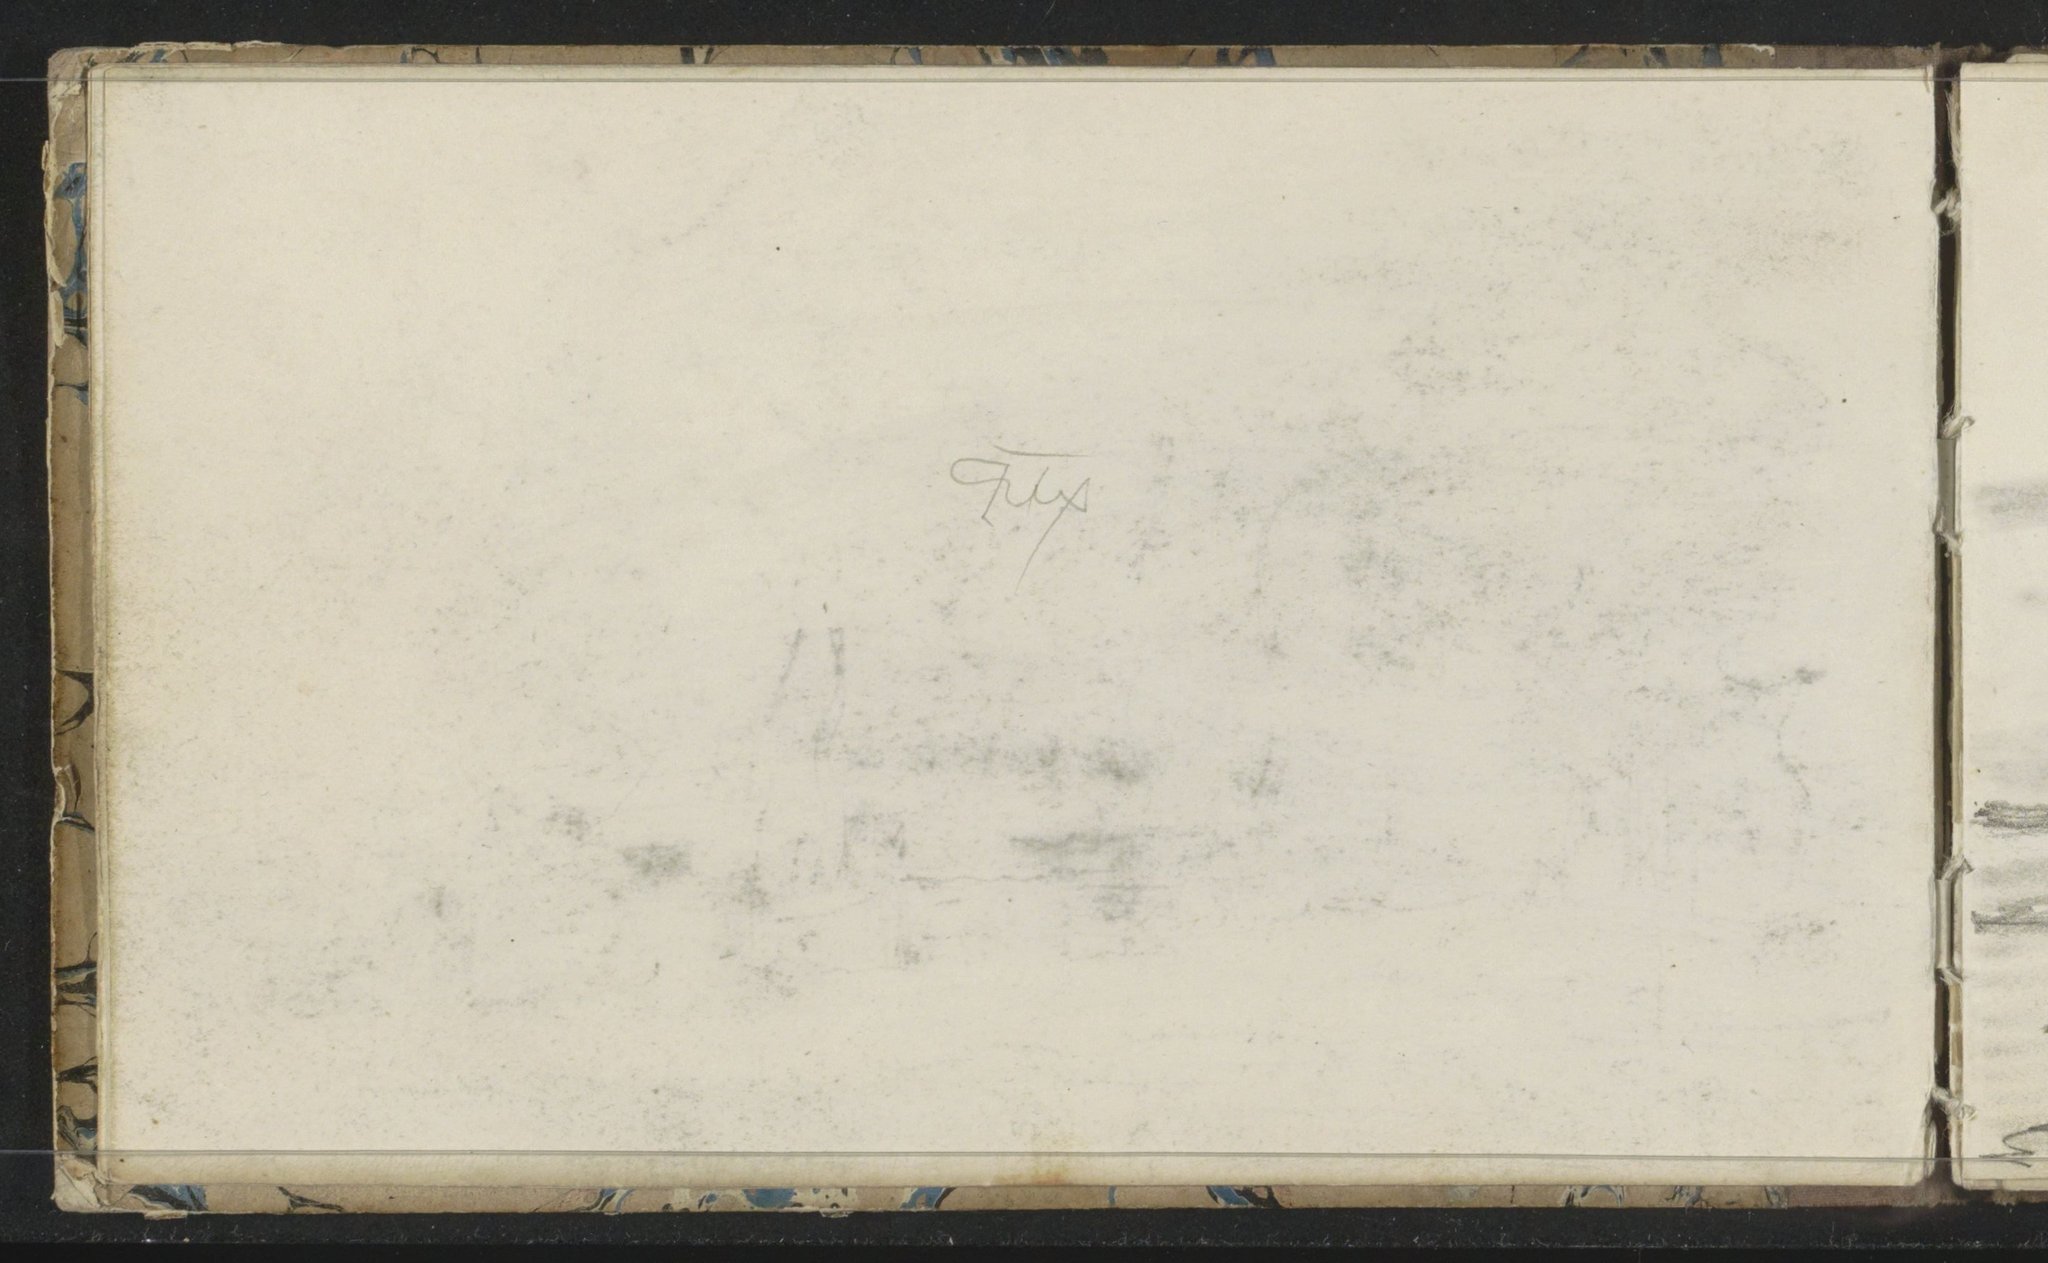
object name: sketchbook leaf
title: Notitie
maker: arnoldus johannes eymer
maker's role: draughtsman, print maker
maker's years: 1803-1863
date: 1803-1818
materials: paper, pencil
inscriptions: annotation: ‘RTp?’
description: Bladzijde 6 uit een schetsboek met 74 bladzijden.